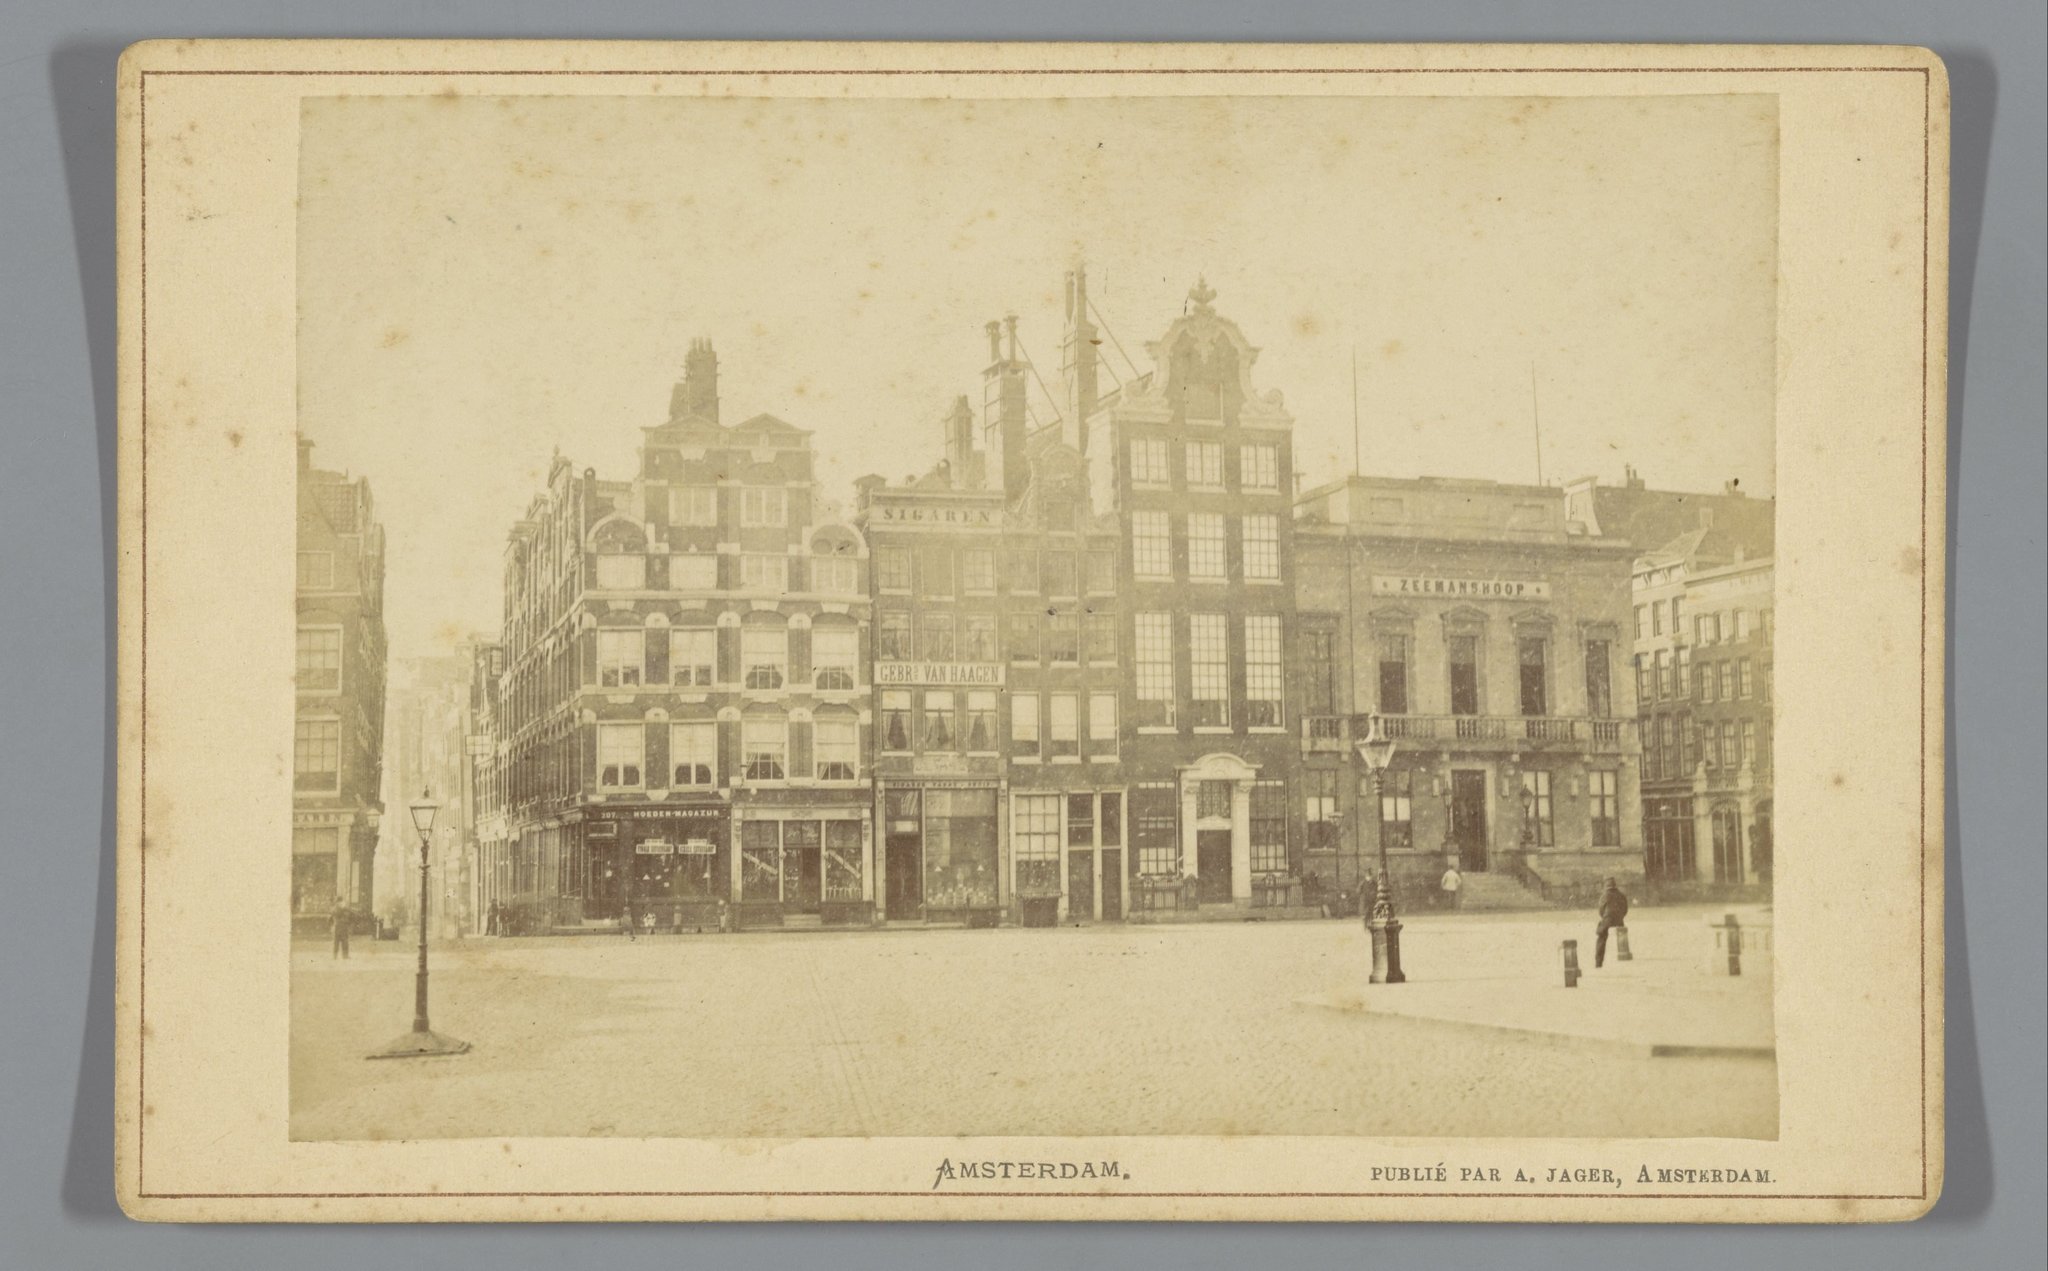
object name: cabinet photograph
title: Amsterdam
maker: andries jager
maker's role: publisher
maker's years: 1825-1905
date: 1860-1890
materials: cardboard, photographic support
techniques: albumen print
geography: amsterdam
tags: shop, store, square, place, circus, etc.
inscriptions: annotation: ‘Beurssteeg met voormalig hoekhuis,/ thans het Sigarenmagazijn van P.G.C./ Hajenius./ 1884.’